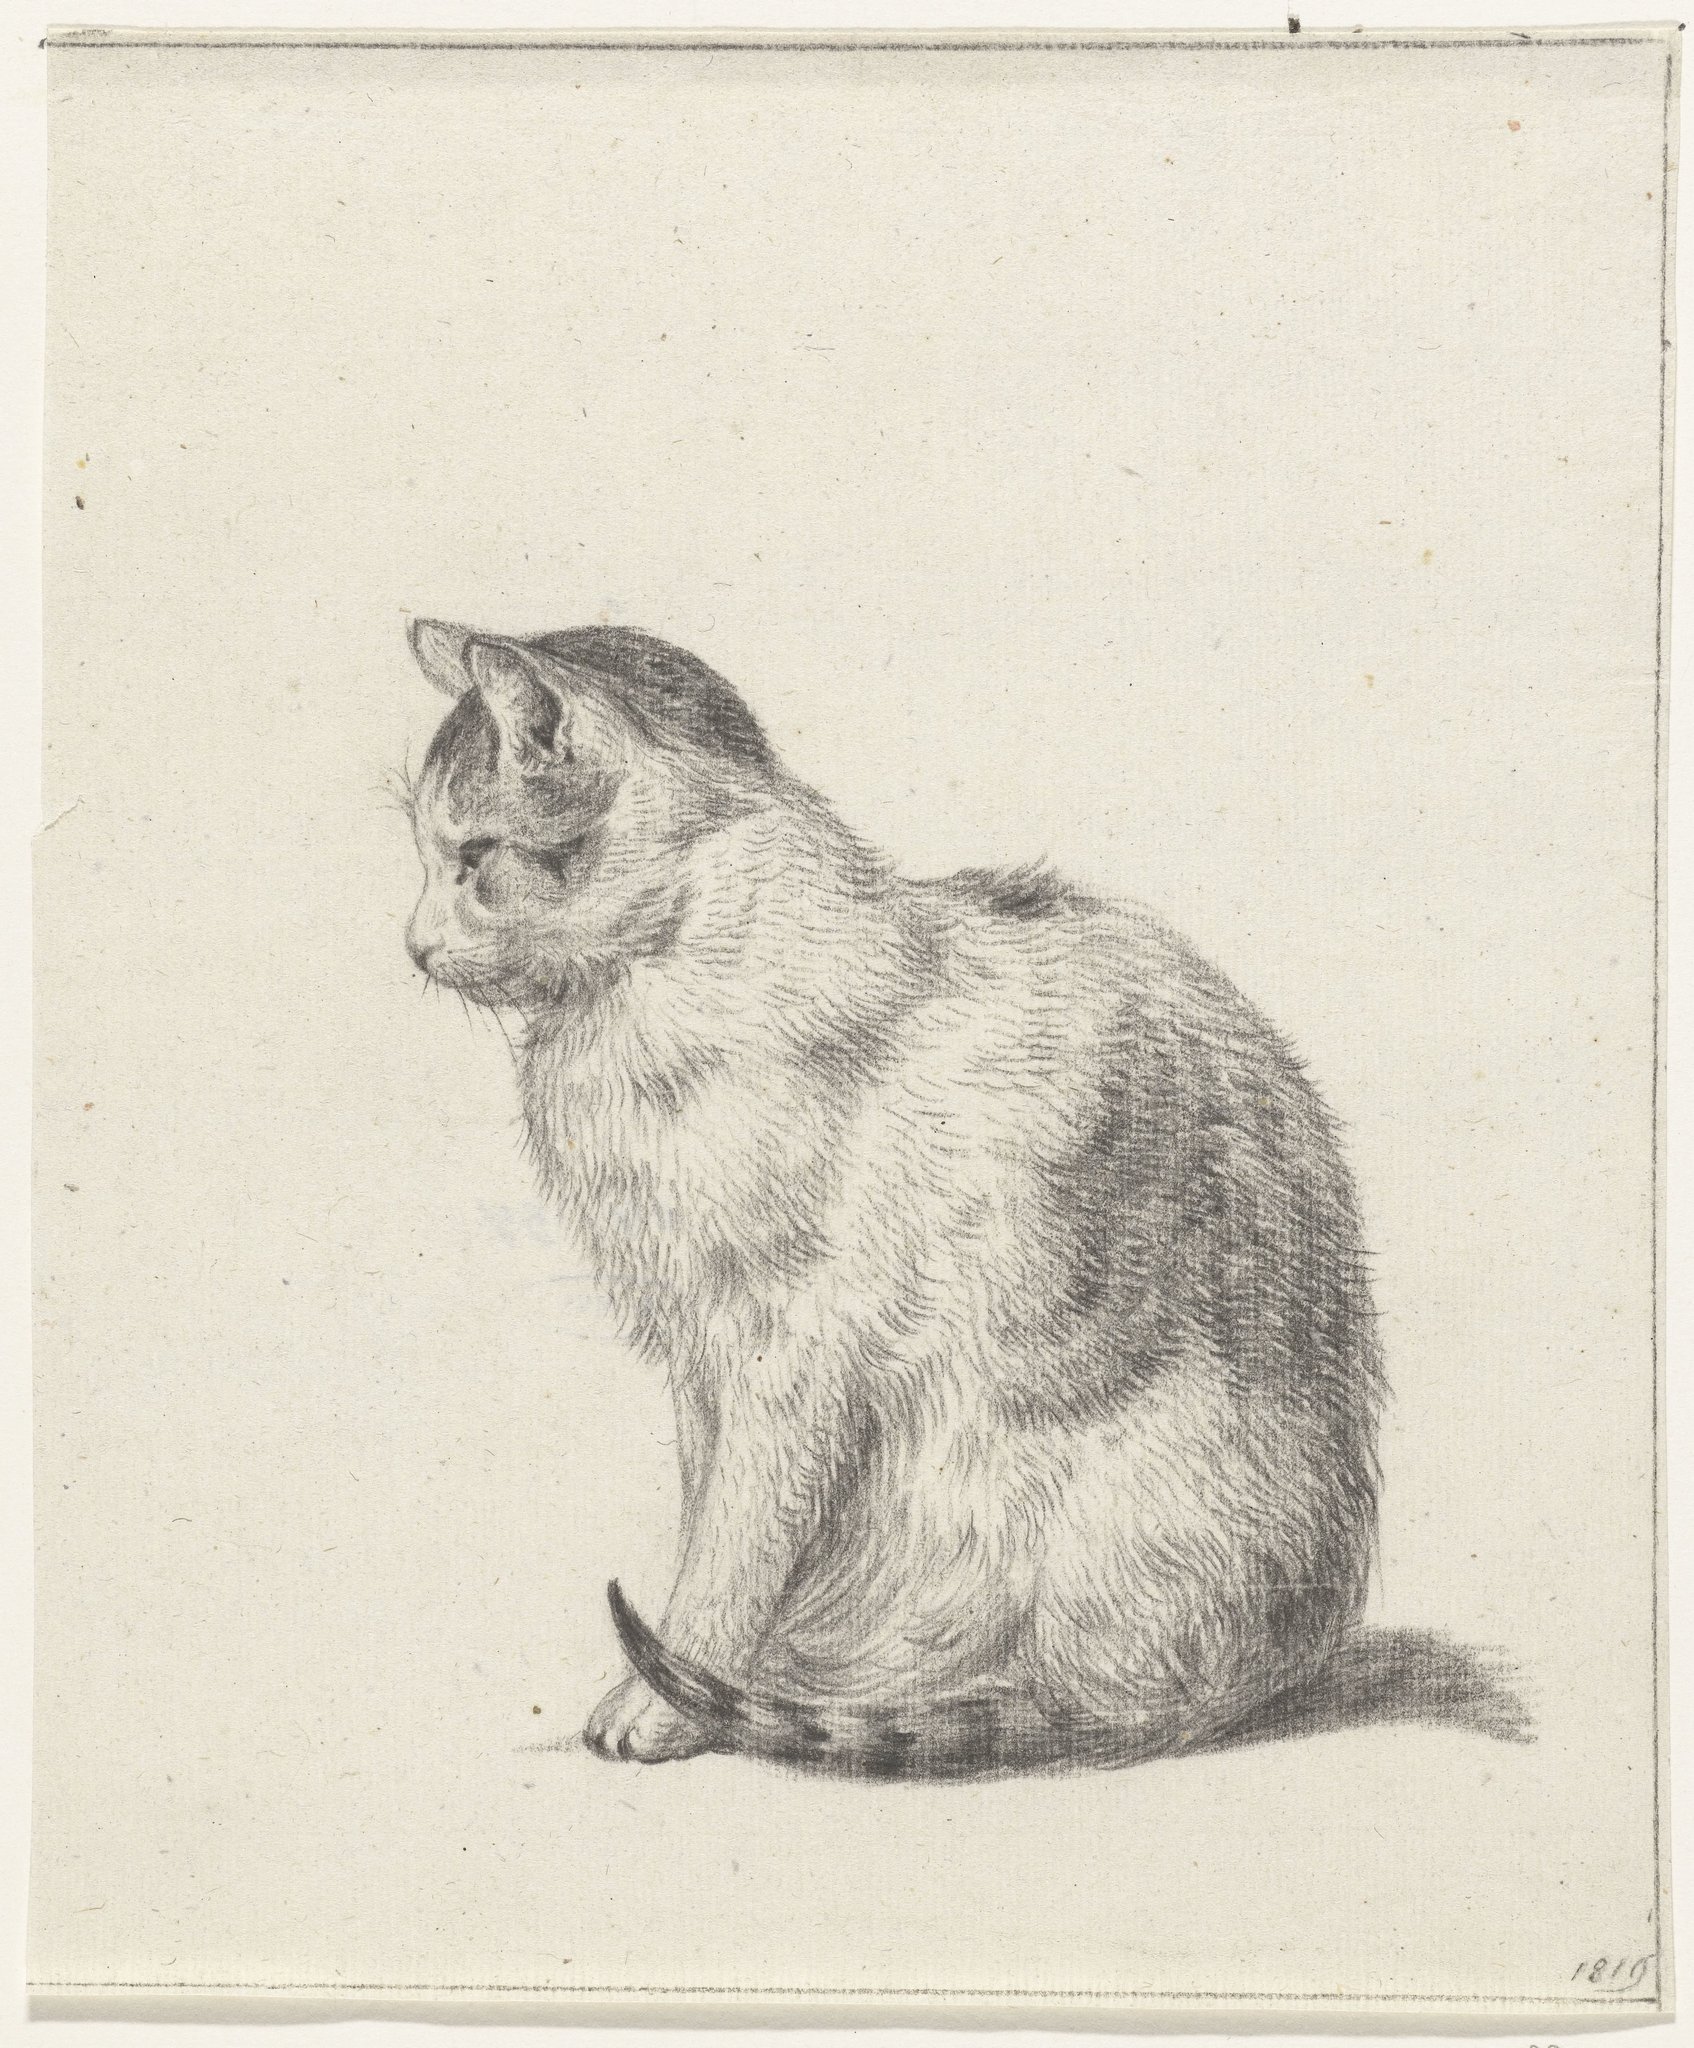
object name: drawing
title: Zittende kat, naar links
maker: jean bernard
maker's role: draughtsman, print maker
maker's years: 1765-1833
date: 1819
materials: chalk, paper, pencil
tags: cat